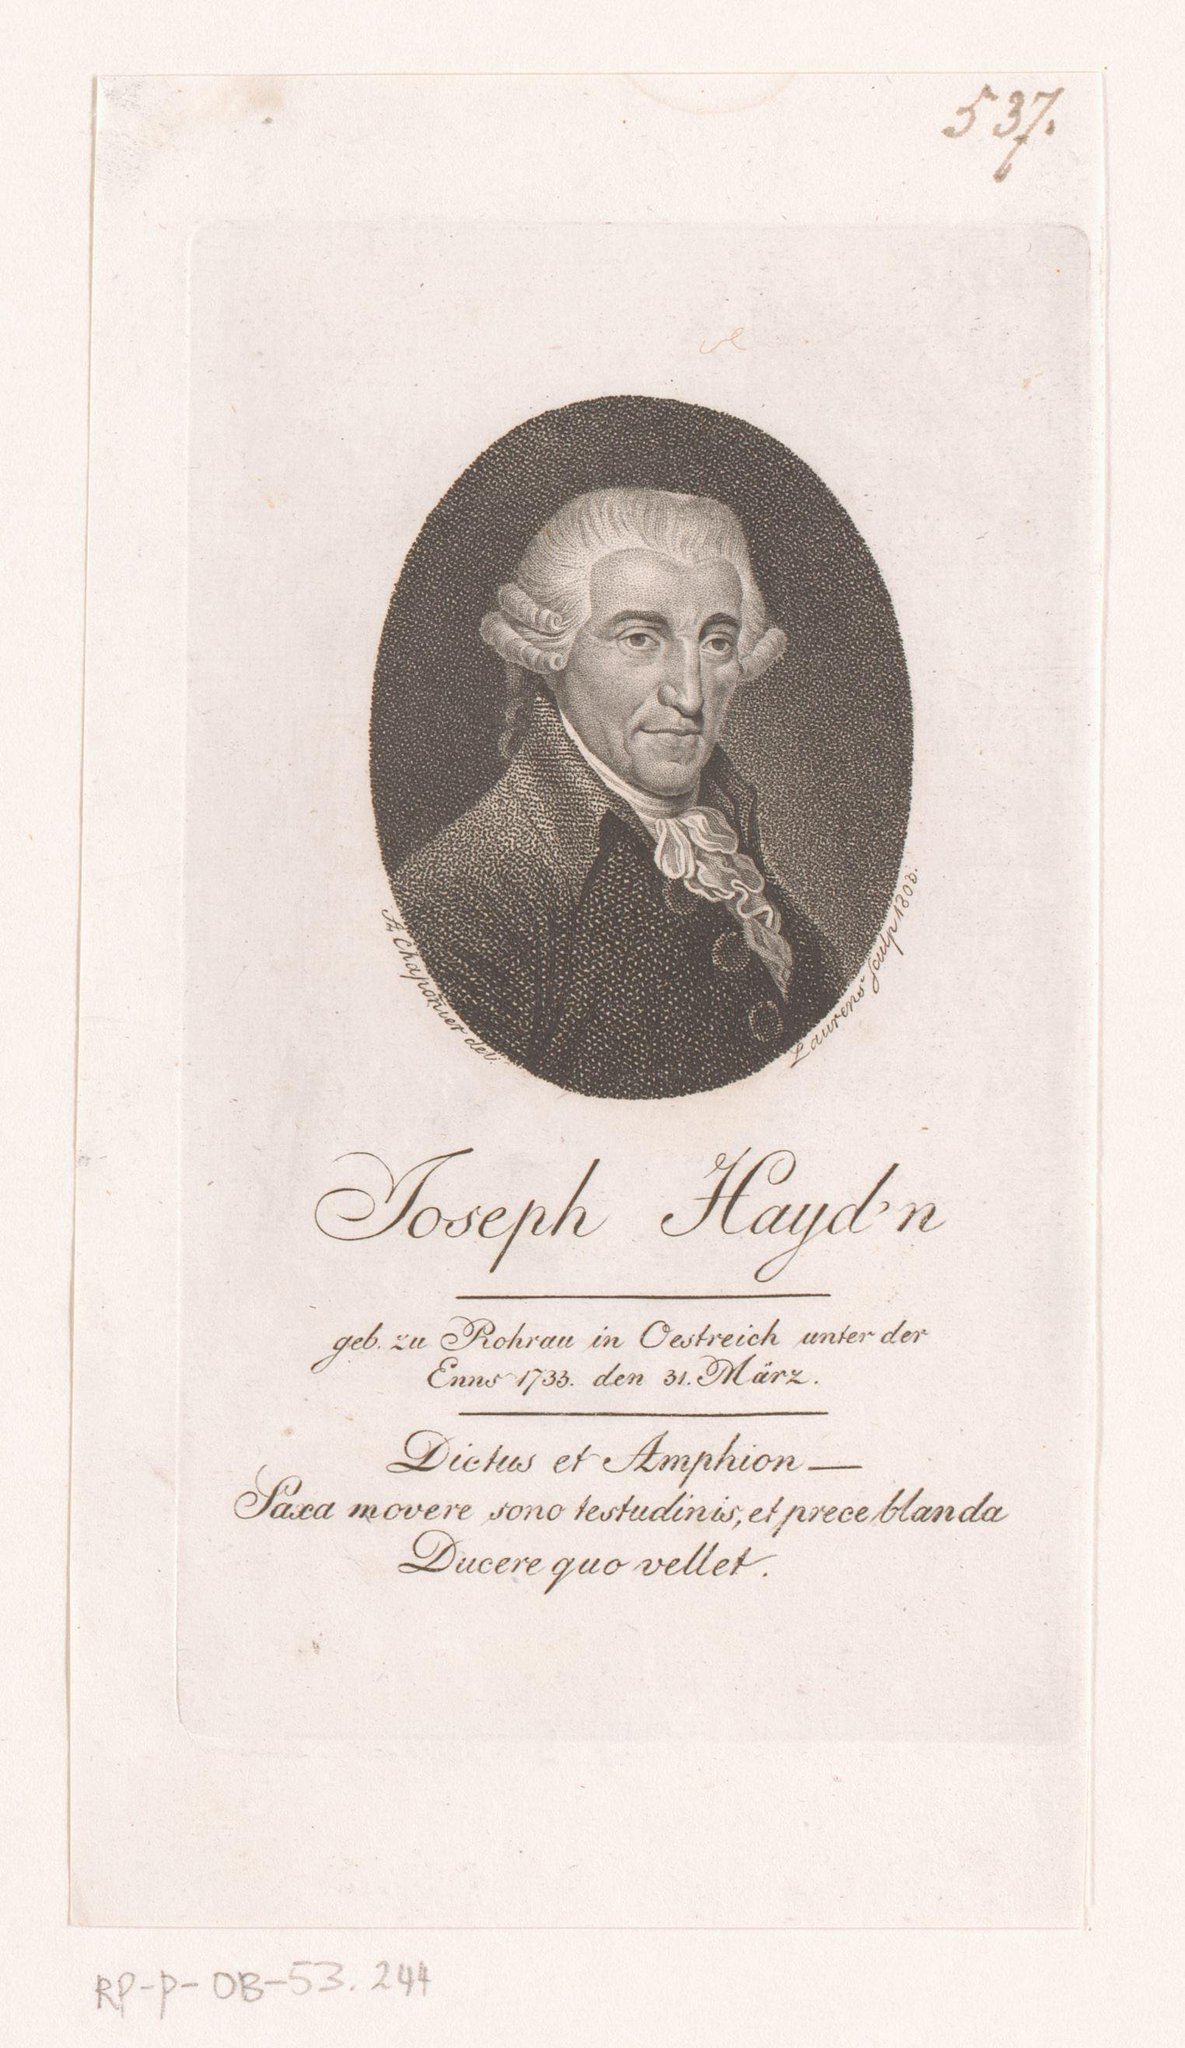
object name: print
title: Portret van Joseph Hadyn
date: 1803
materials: paper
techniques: stippling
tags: vienna, historical persons, portrait of composer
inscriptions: collector's mark: Lugt 2228